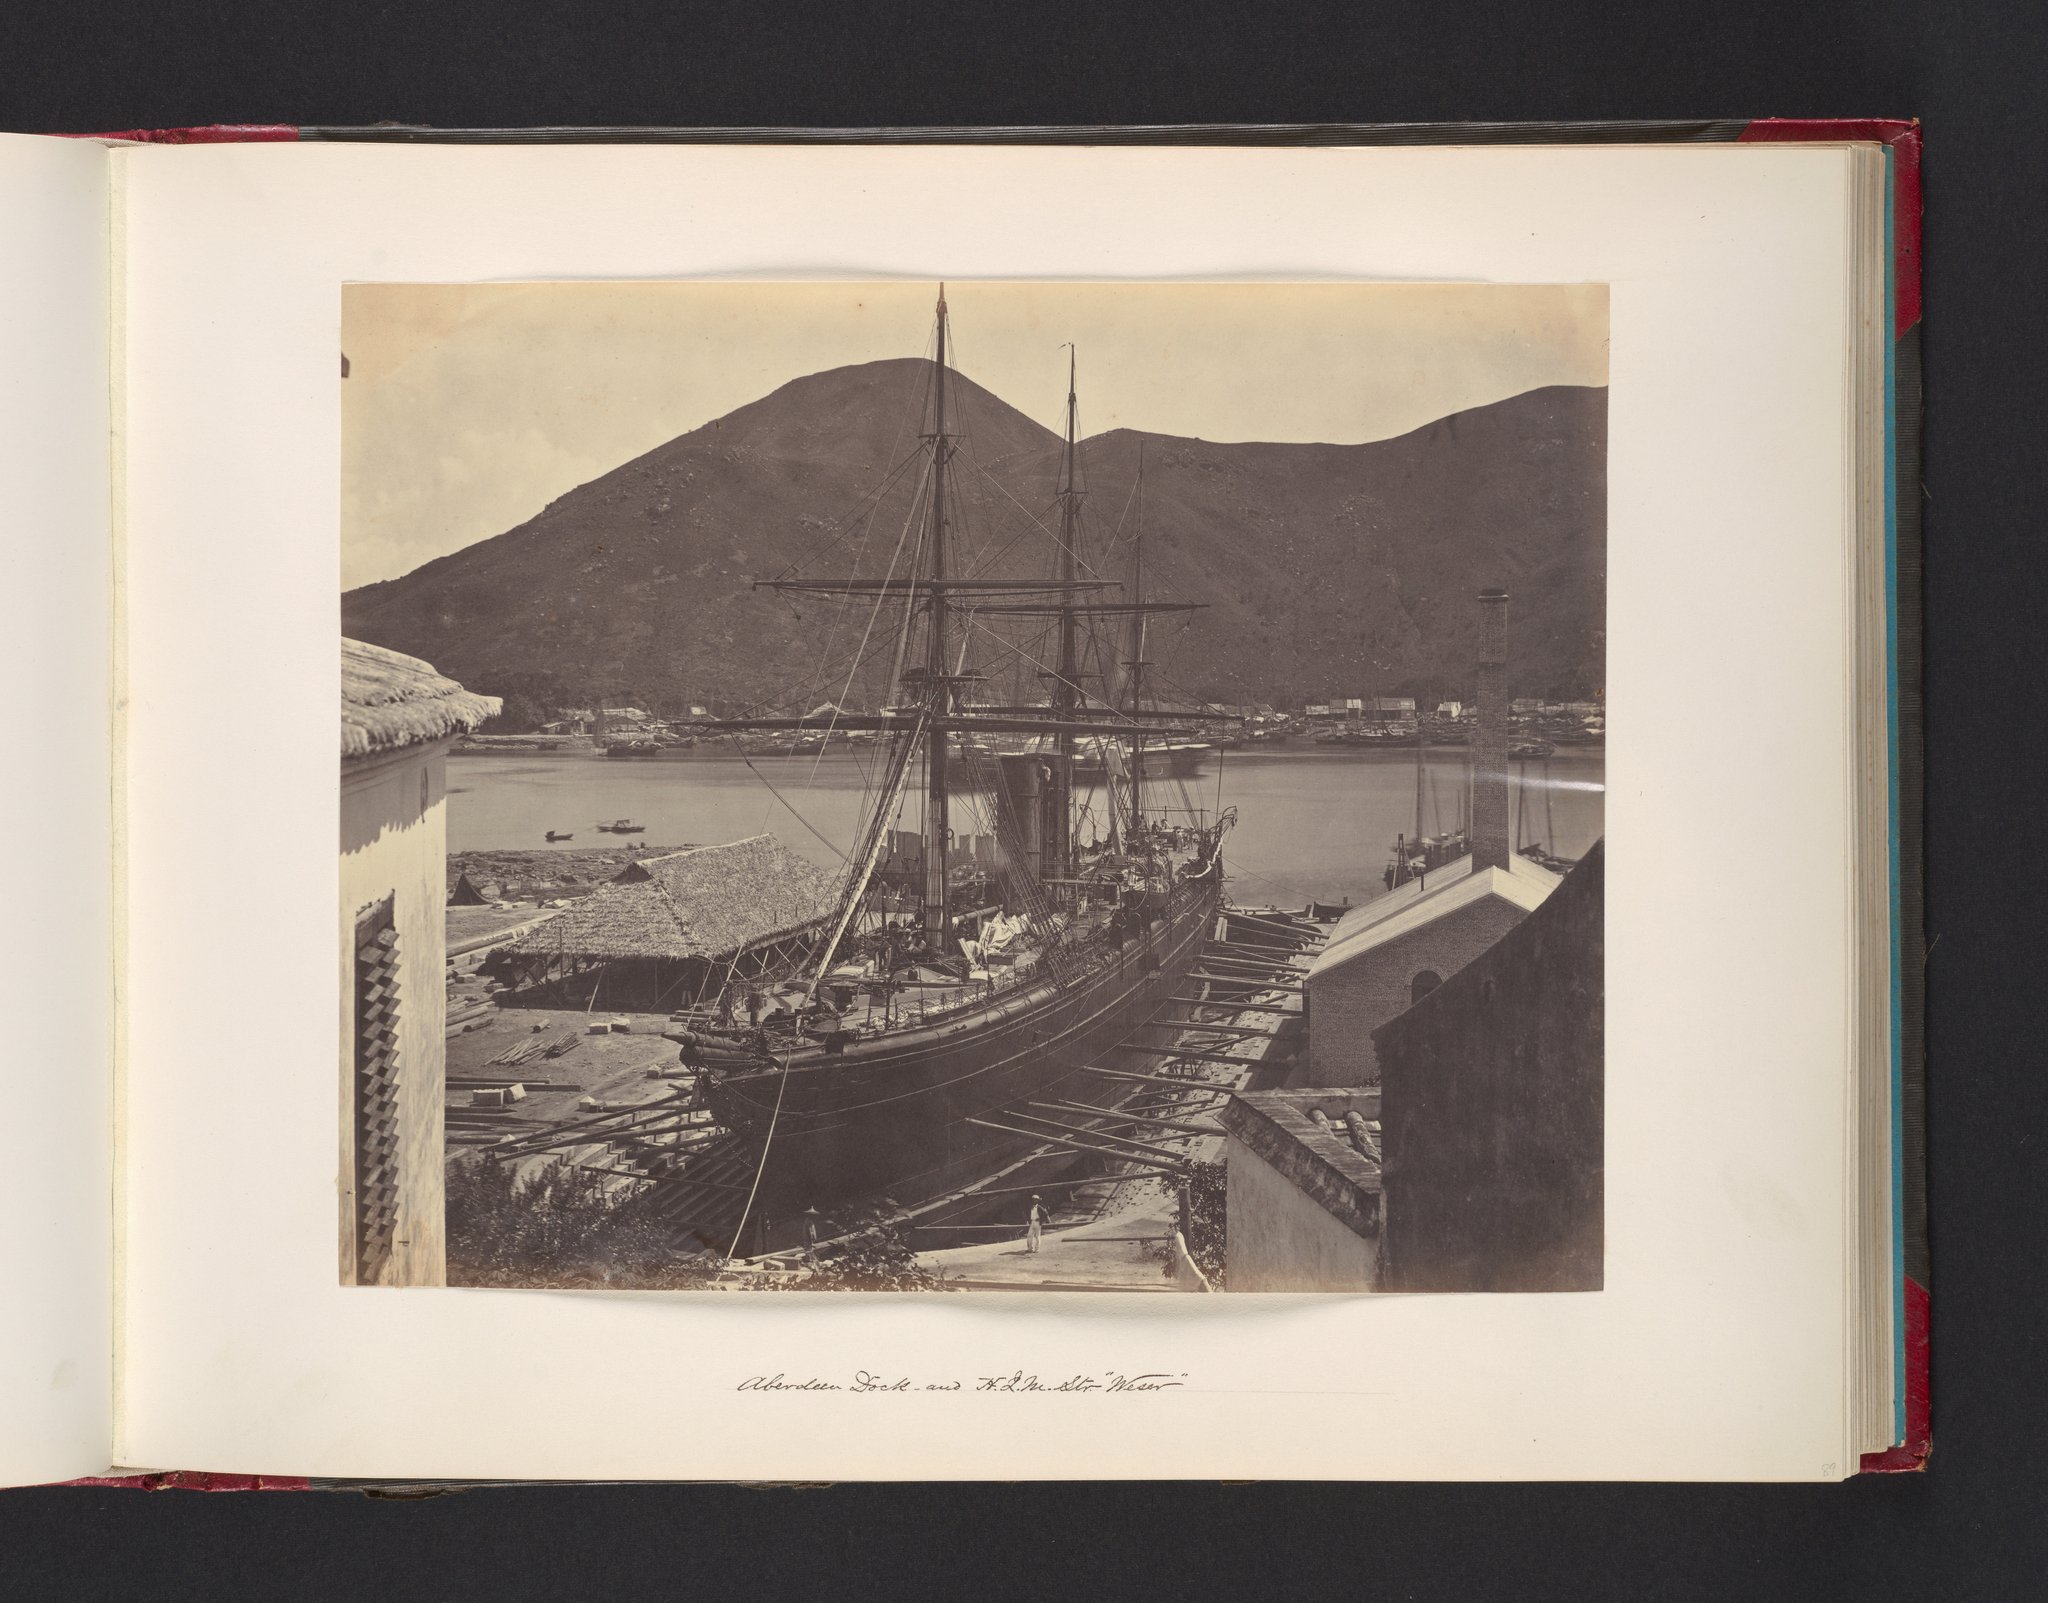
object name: photograph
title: [Dock and Boat]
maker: john thomson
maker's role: artist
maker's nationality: british, scottish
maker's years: 1837-1921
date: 1865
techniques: albumen silver print, glass negative